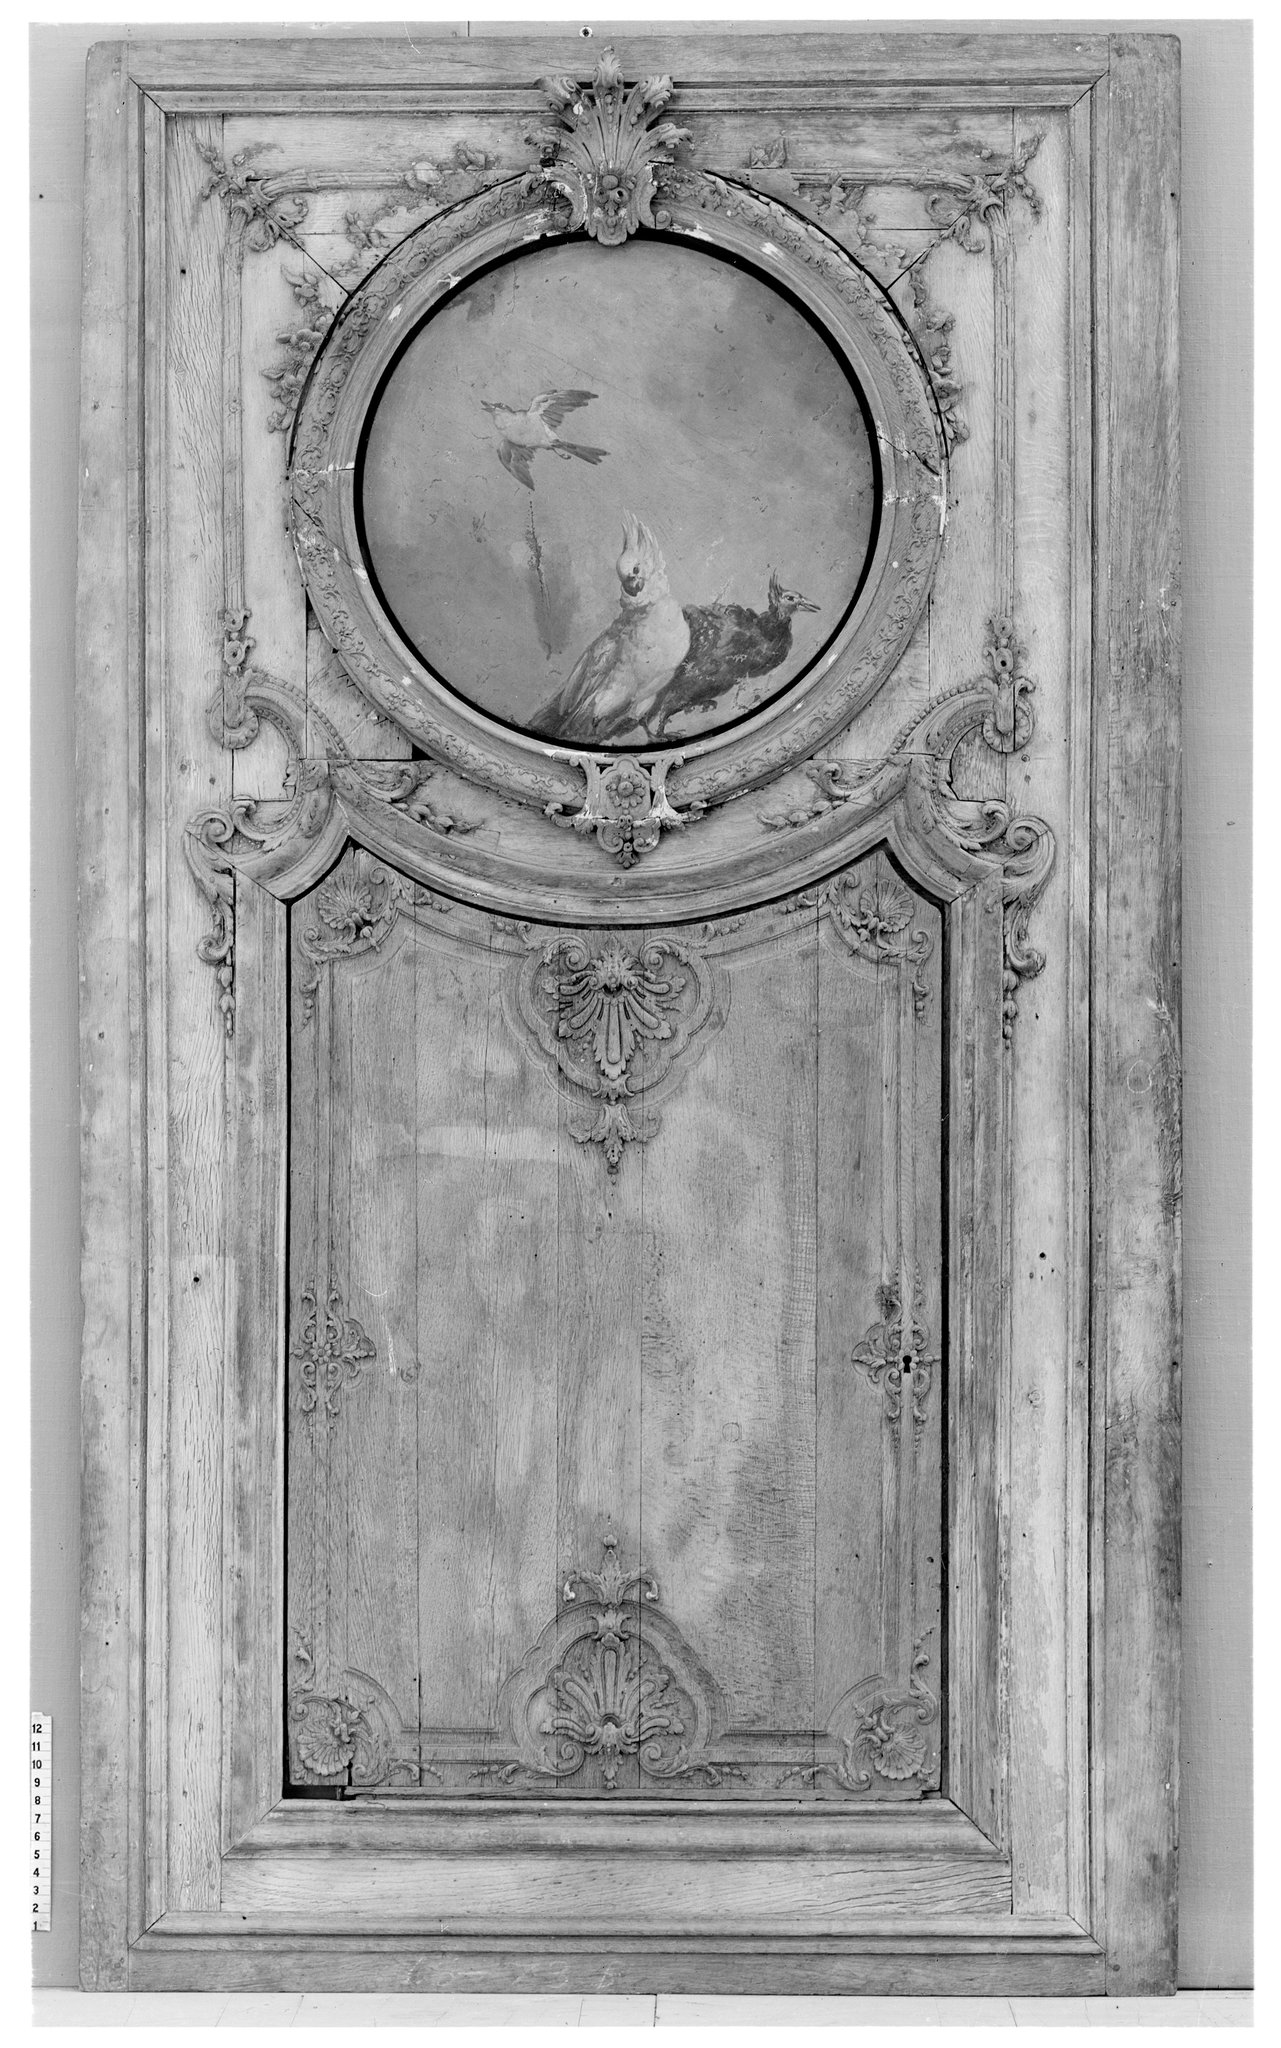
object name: door panel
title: Door panel (part of a set)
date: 1701-1725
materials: wood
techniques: carving, painting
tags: birds